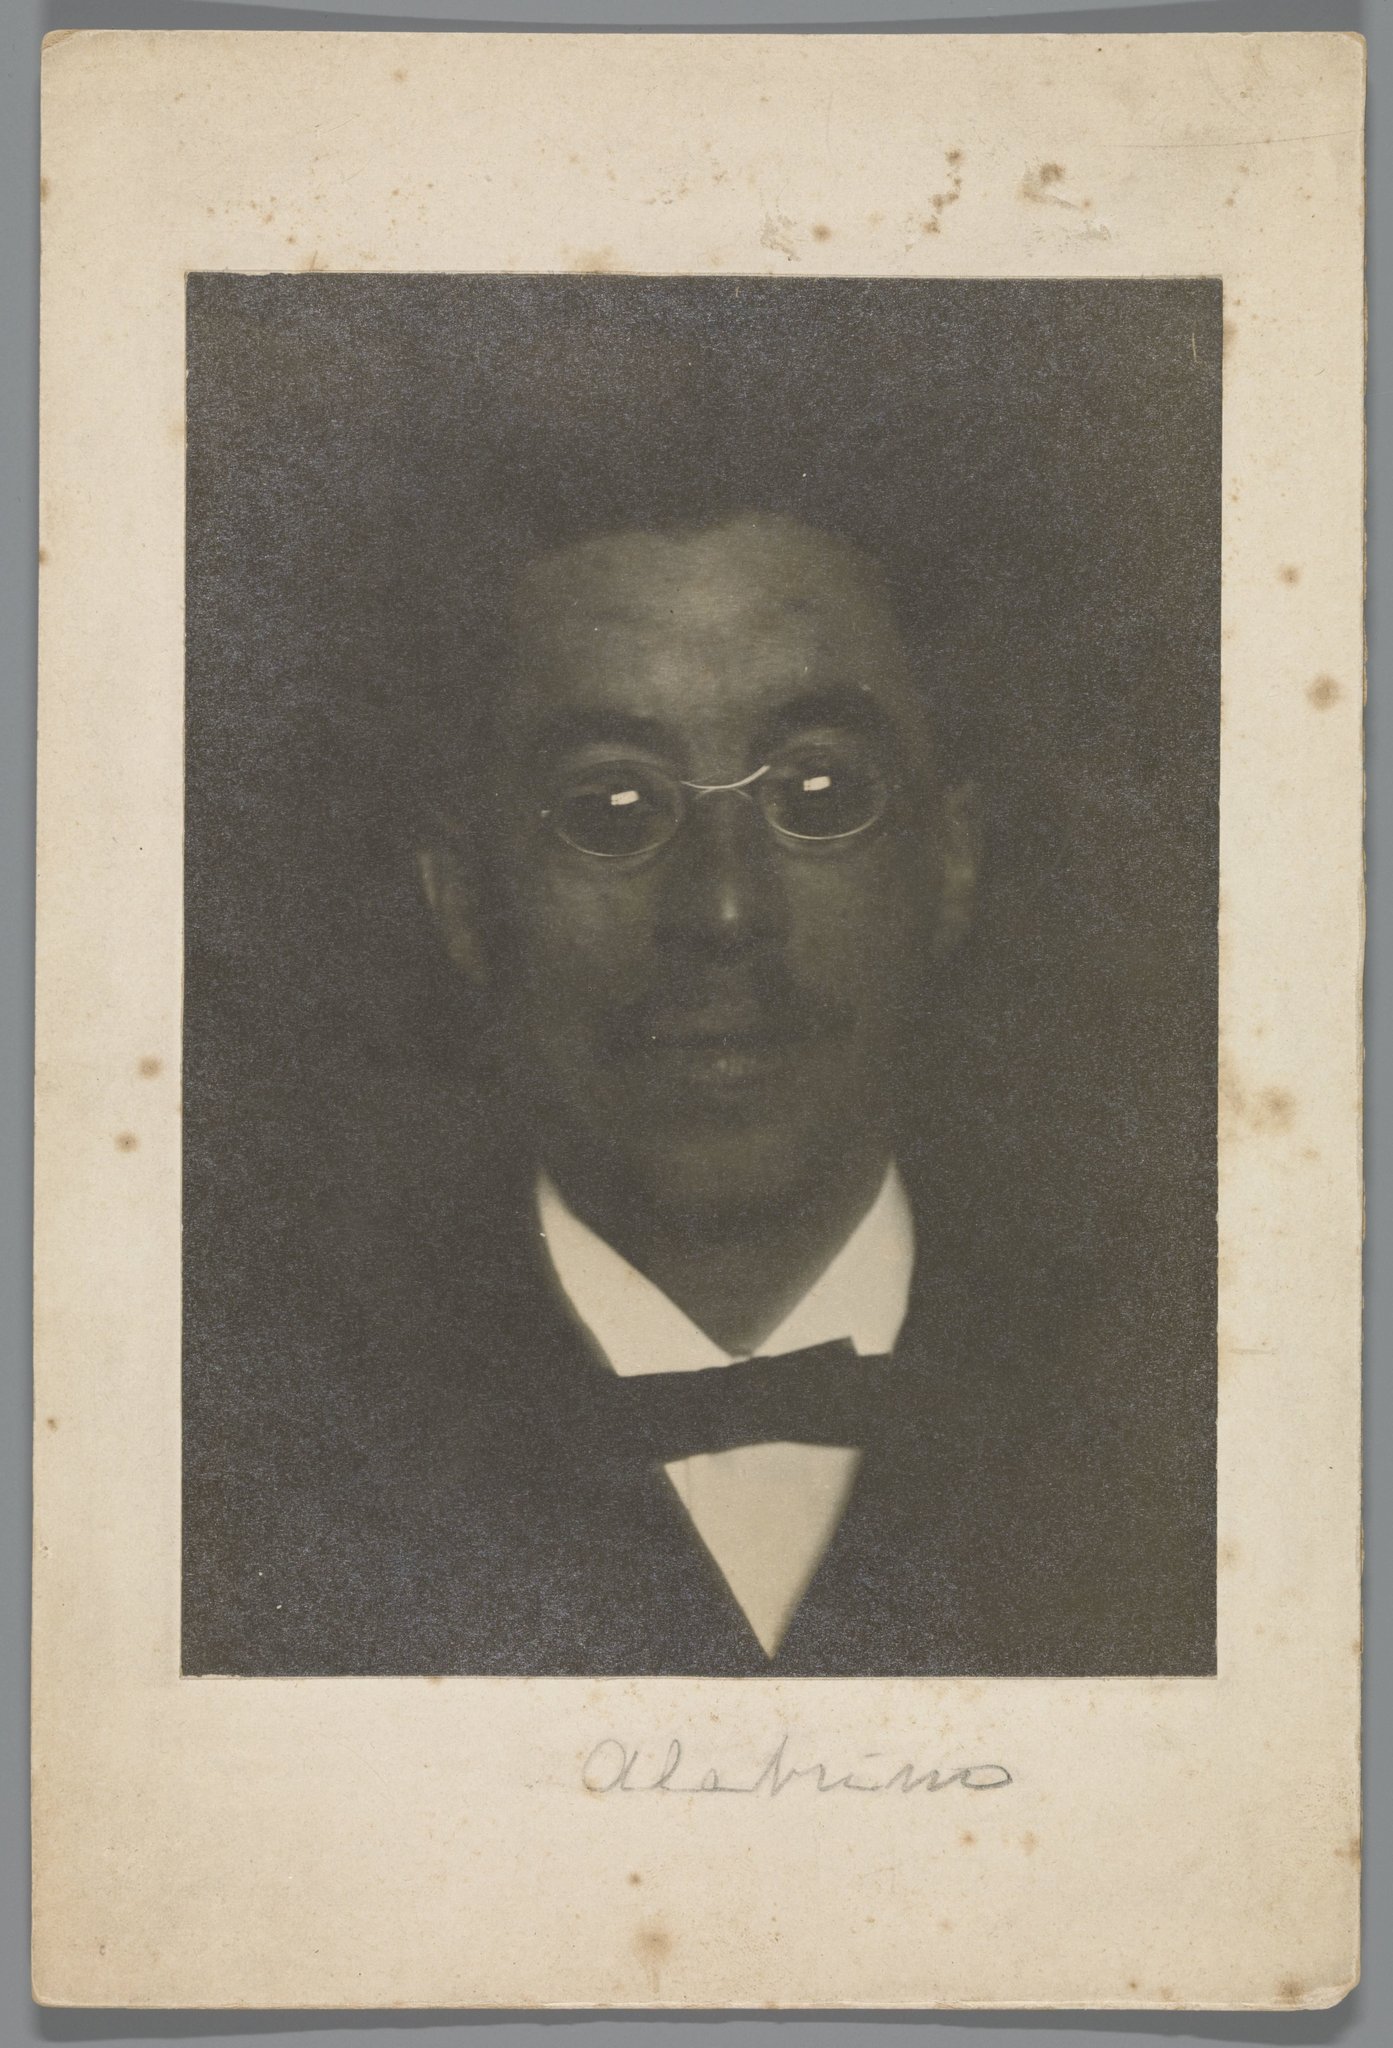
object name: photograph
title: Arnold Aletrino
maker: willem witsen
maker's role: draughtsman, painter, print maker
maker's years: 1860-1923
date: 1860-1915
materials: cardboard, paper, photographic support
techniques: gelatin silver print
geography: amsterdam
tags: amsterdam